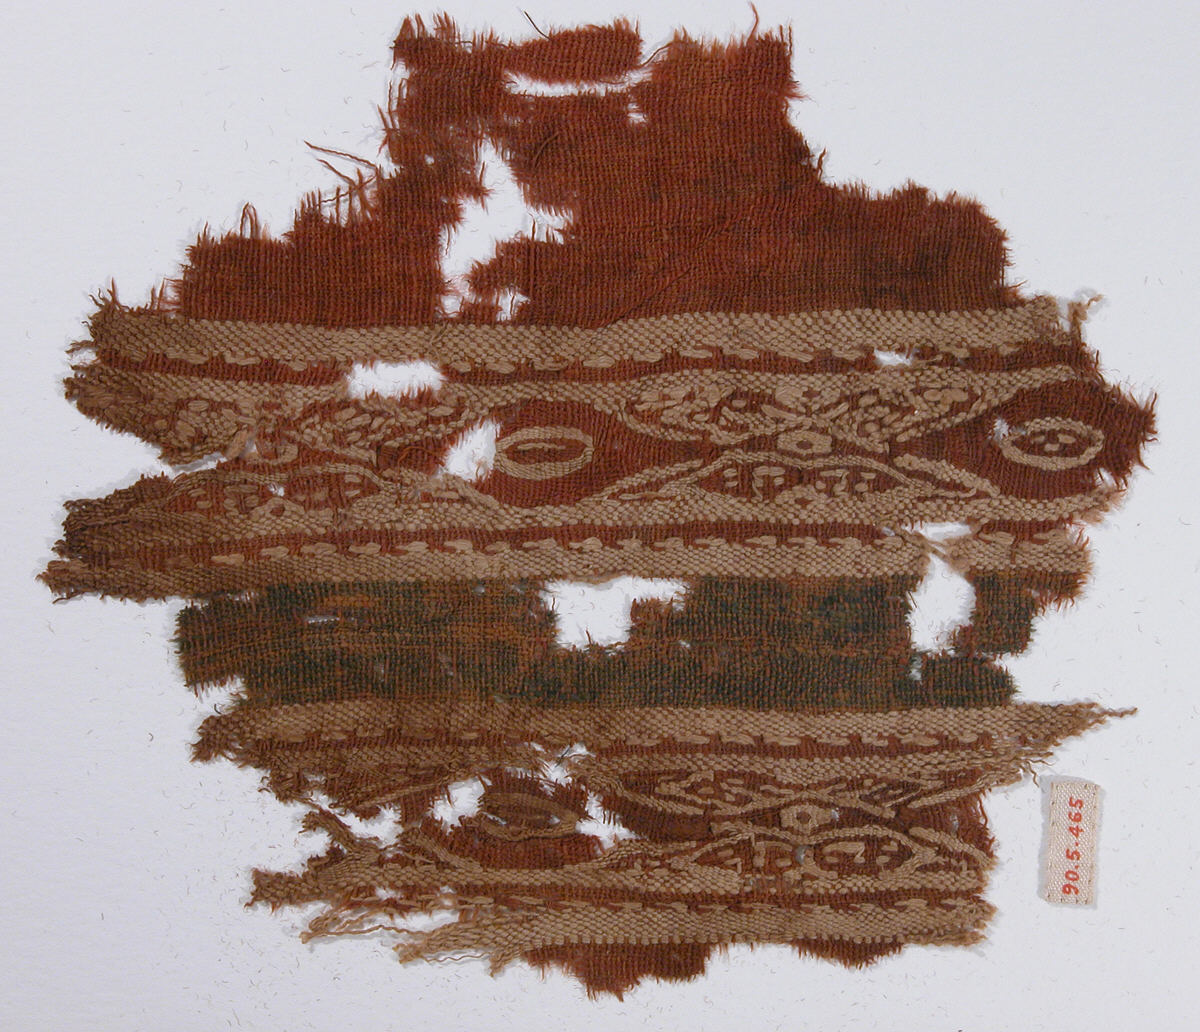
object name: textile fragment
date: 401-500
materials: linen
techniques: weave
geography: egypt